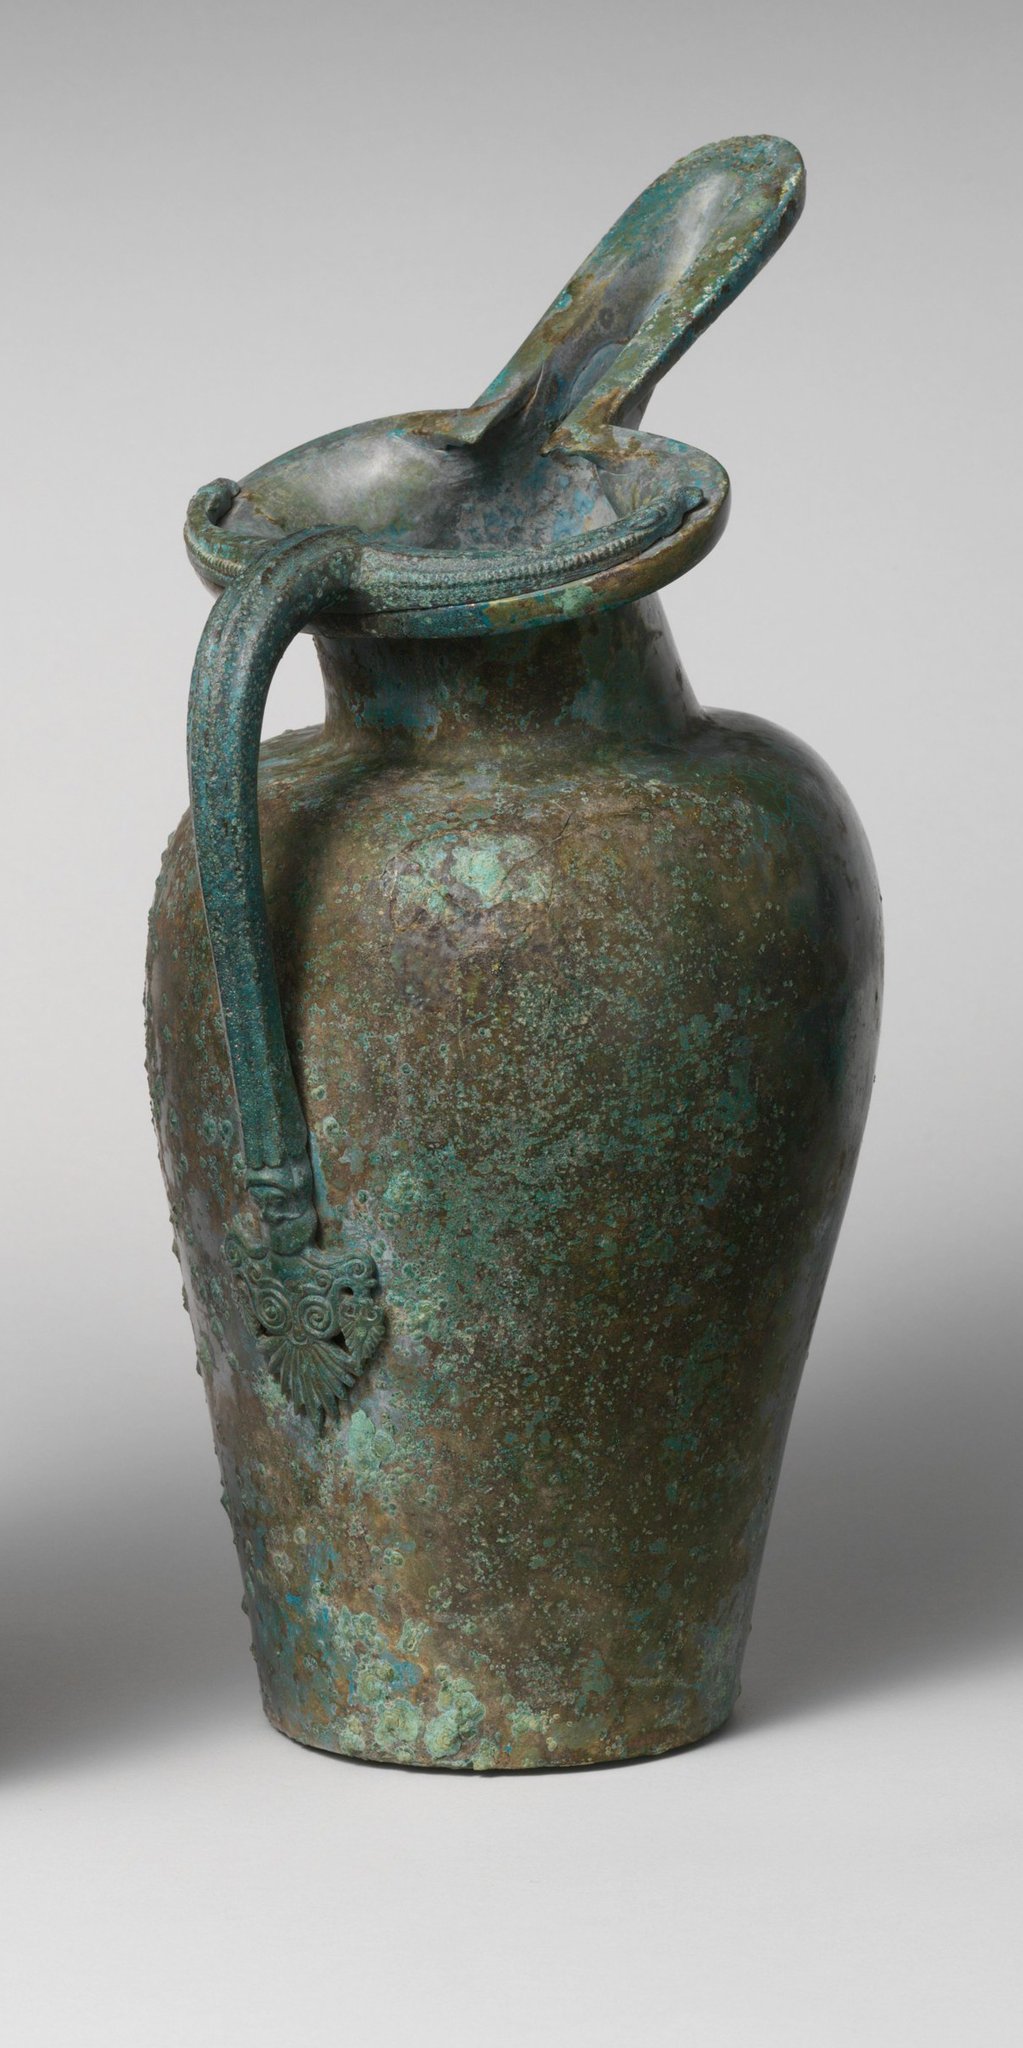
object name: jug with satyr on handle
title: Bronze oinochoe (jug)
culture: etruscan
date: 450-400 BCE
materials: bronze